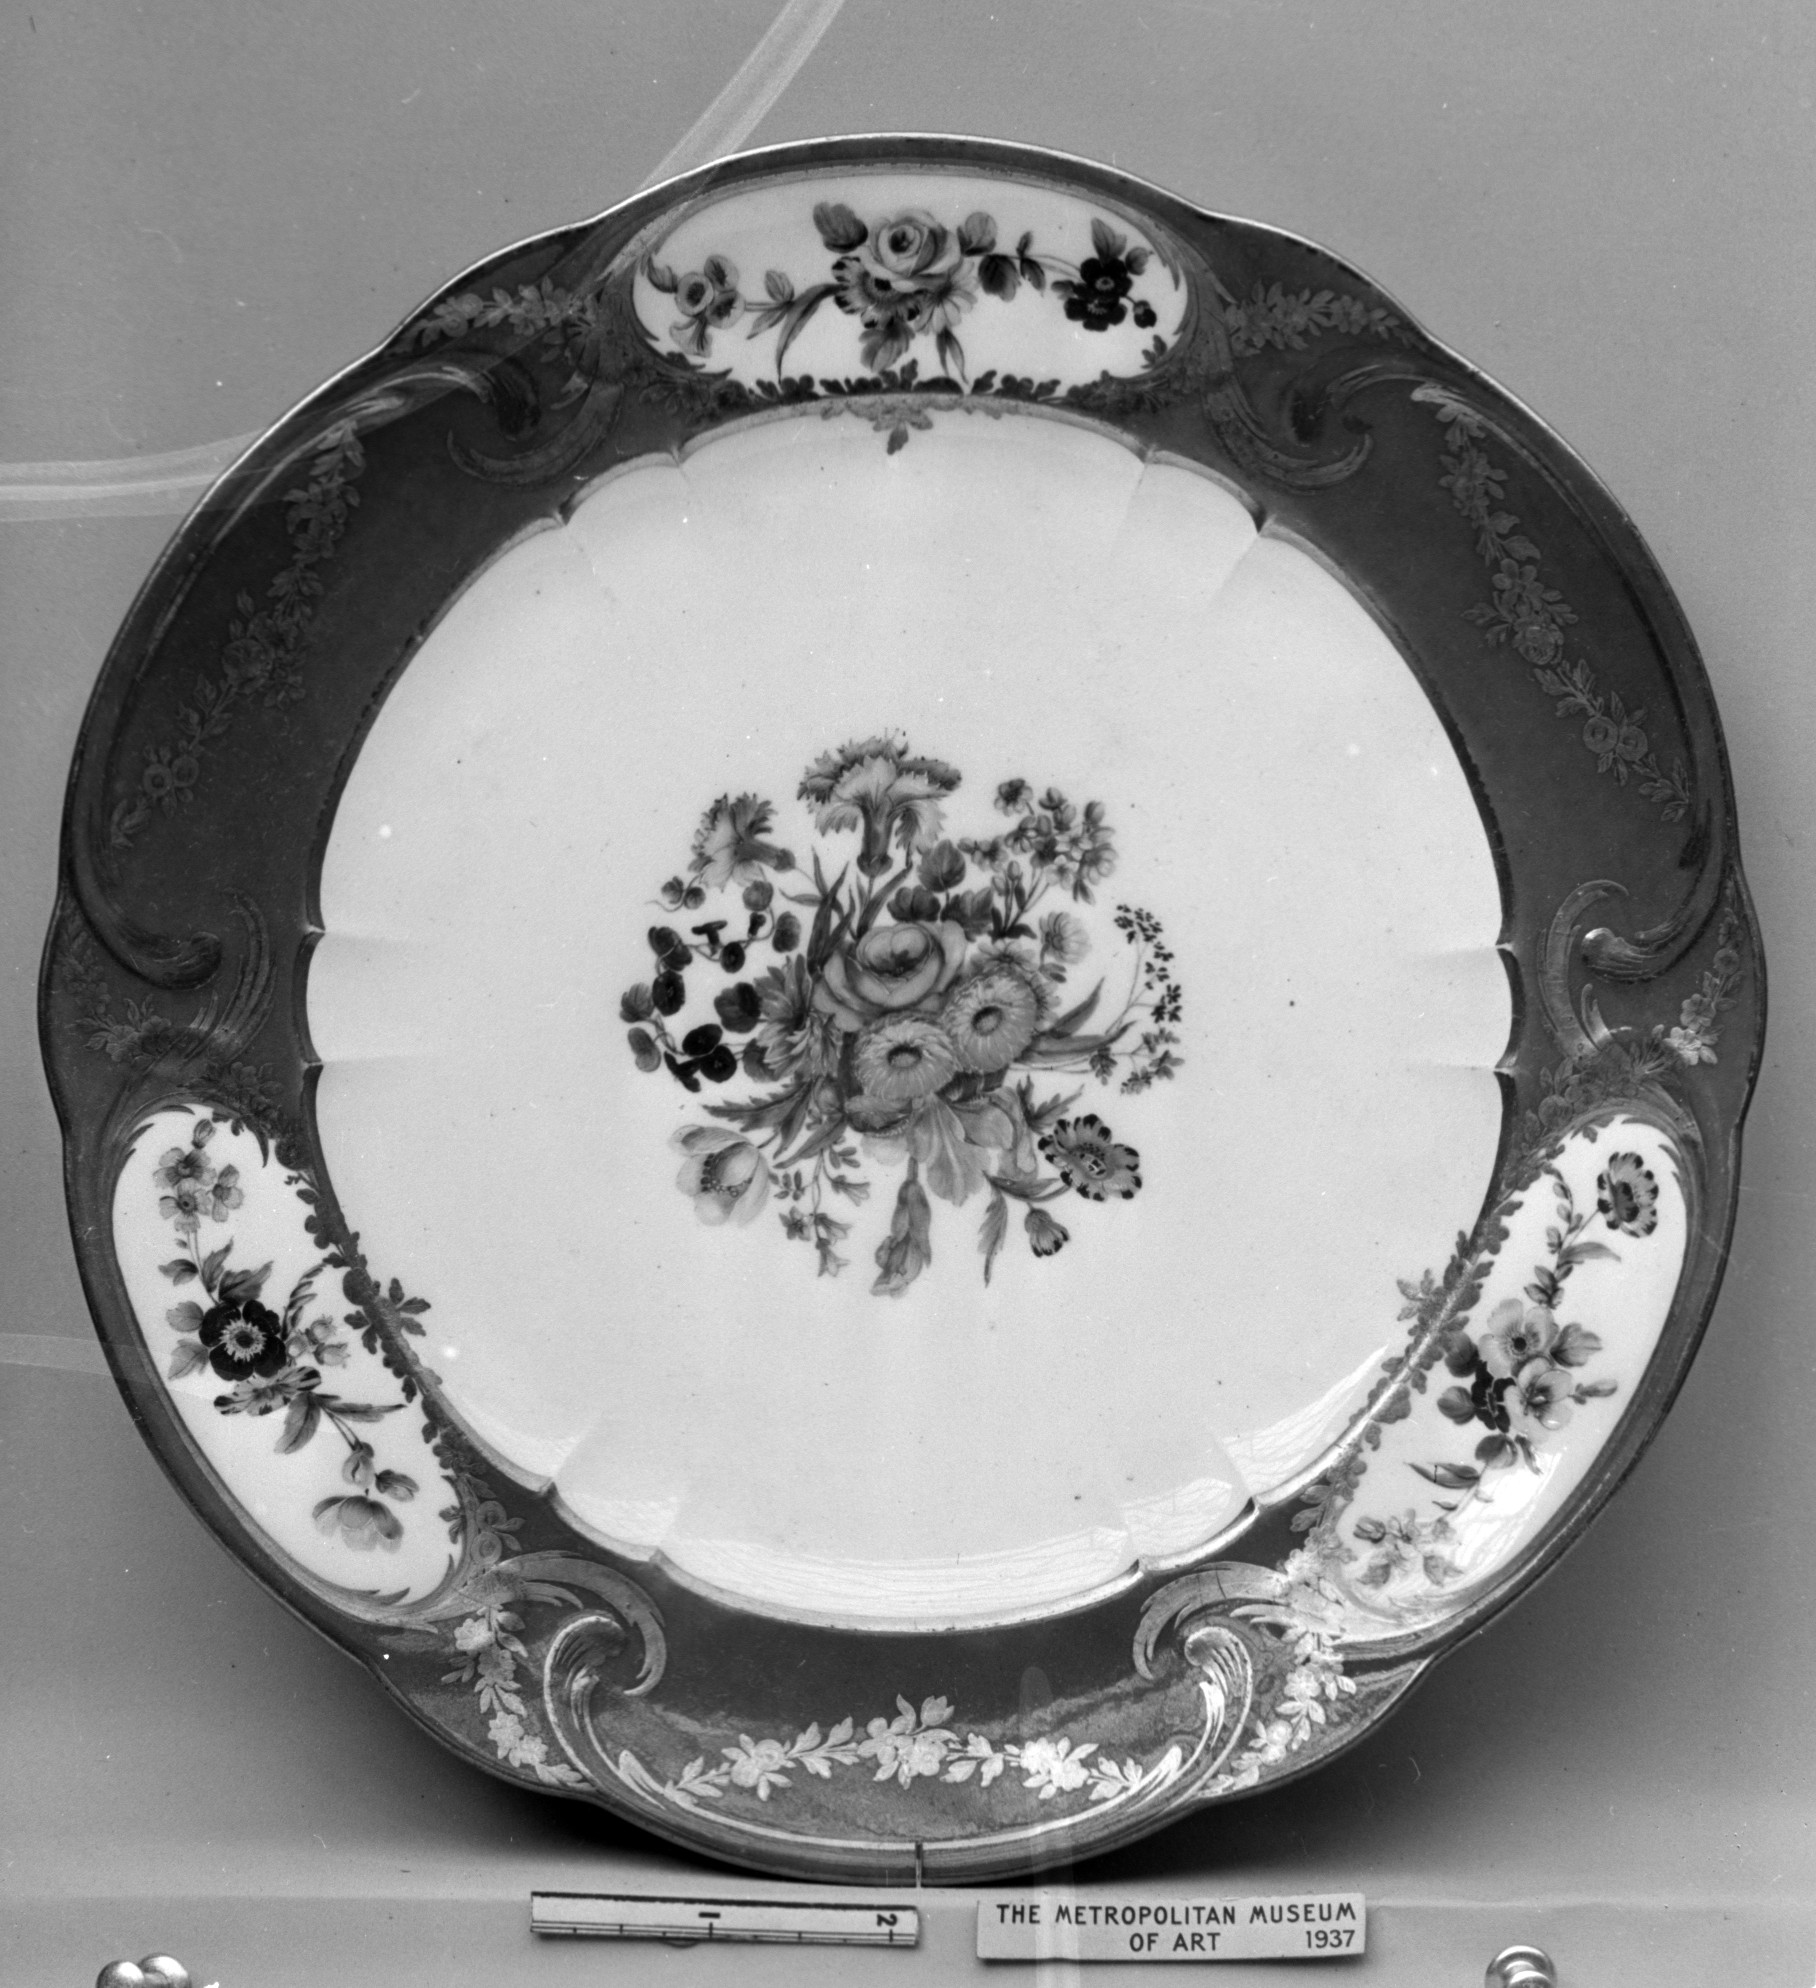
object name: plate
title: Plate (Assiette à palmes) (1 of 102) (part of a service)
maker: sèvres manufactory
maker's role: manufactory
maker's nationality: french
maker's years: 1740-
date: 1772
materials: soft paste porcelain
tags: flowers